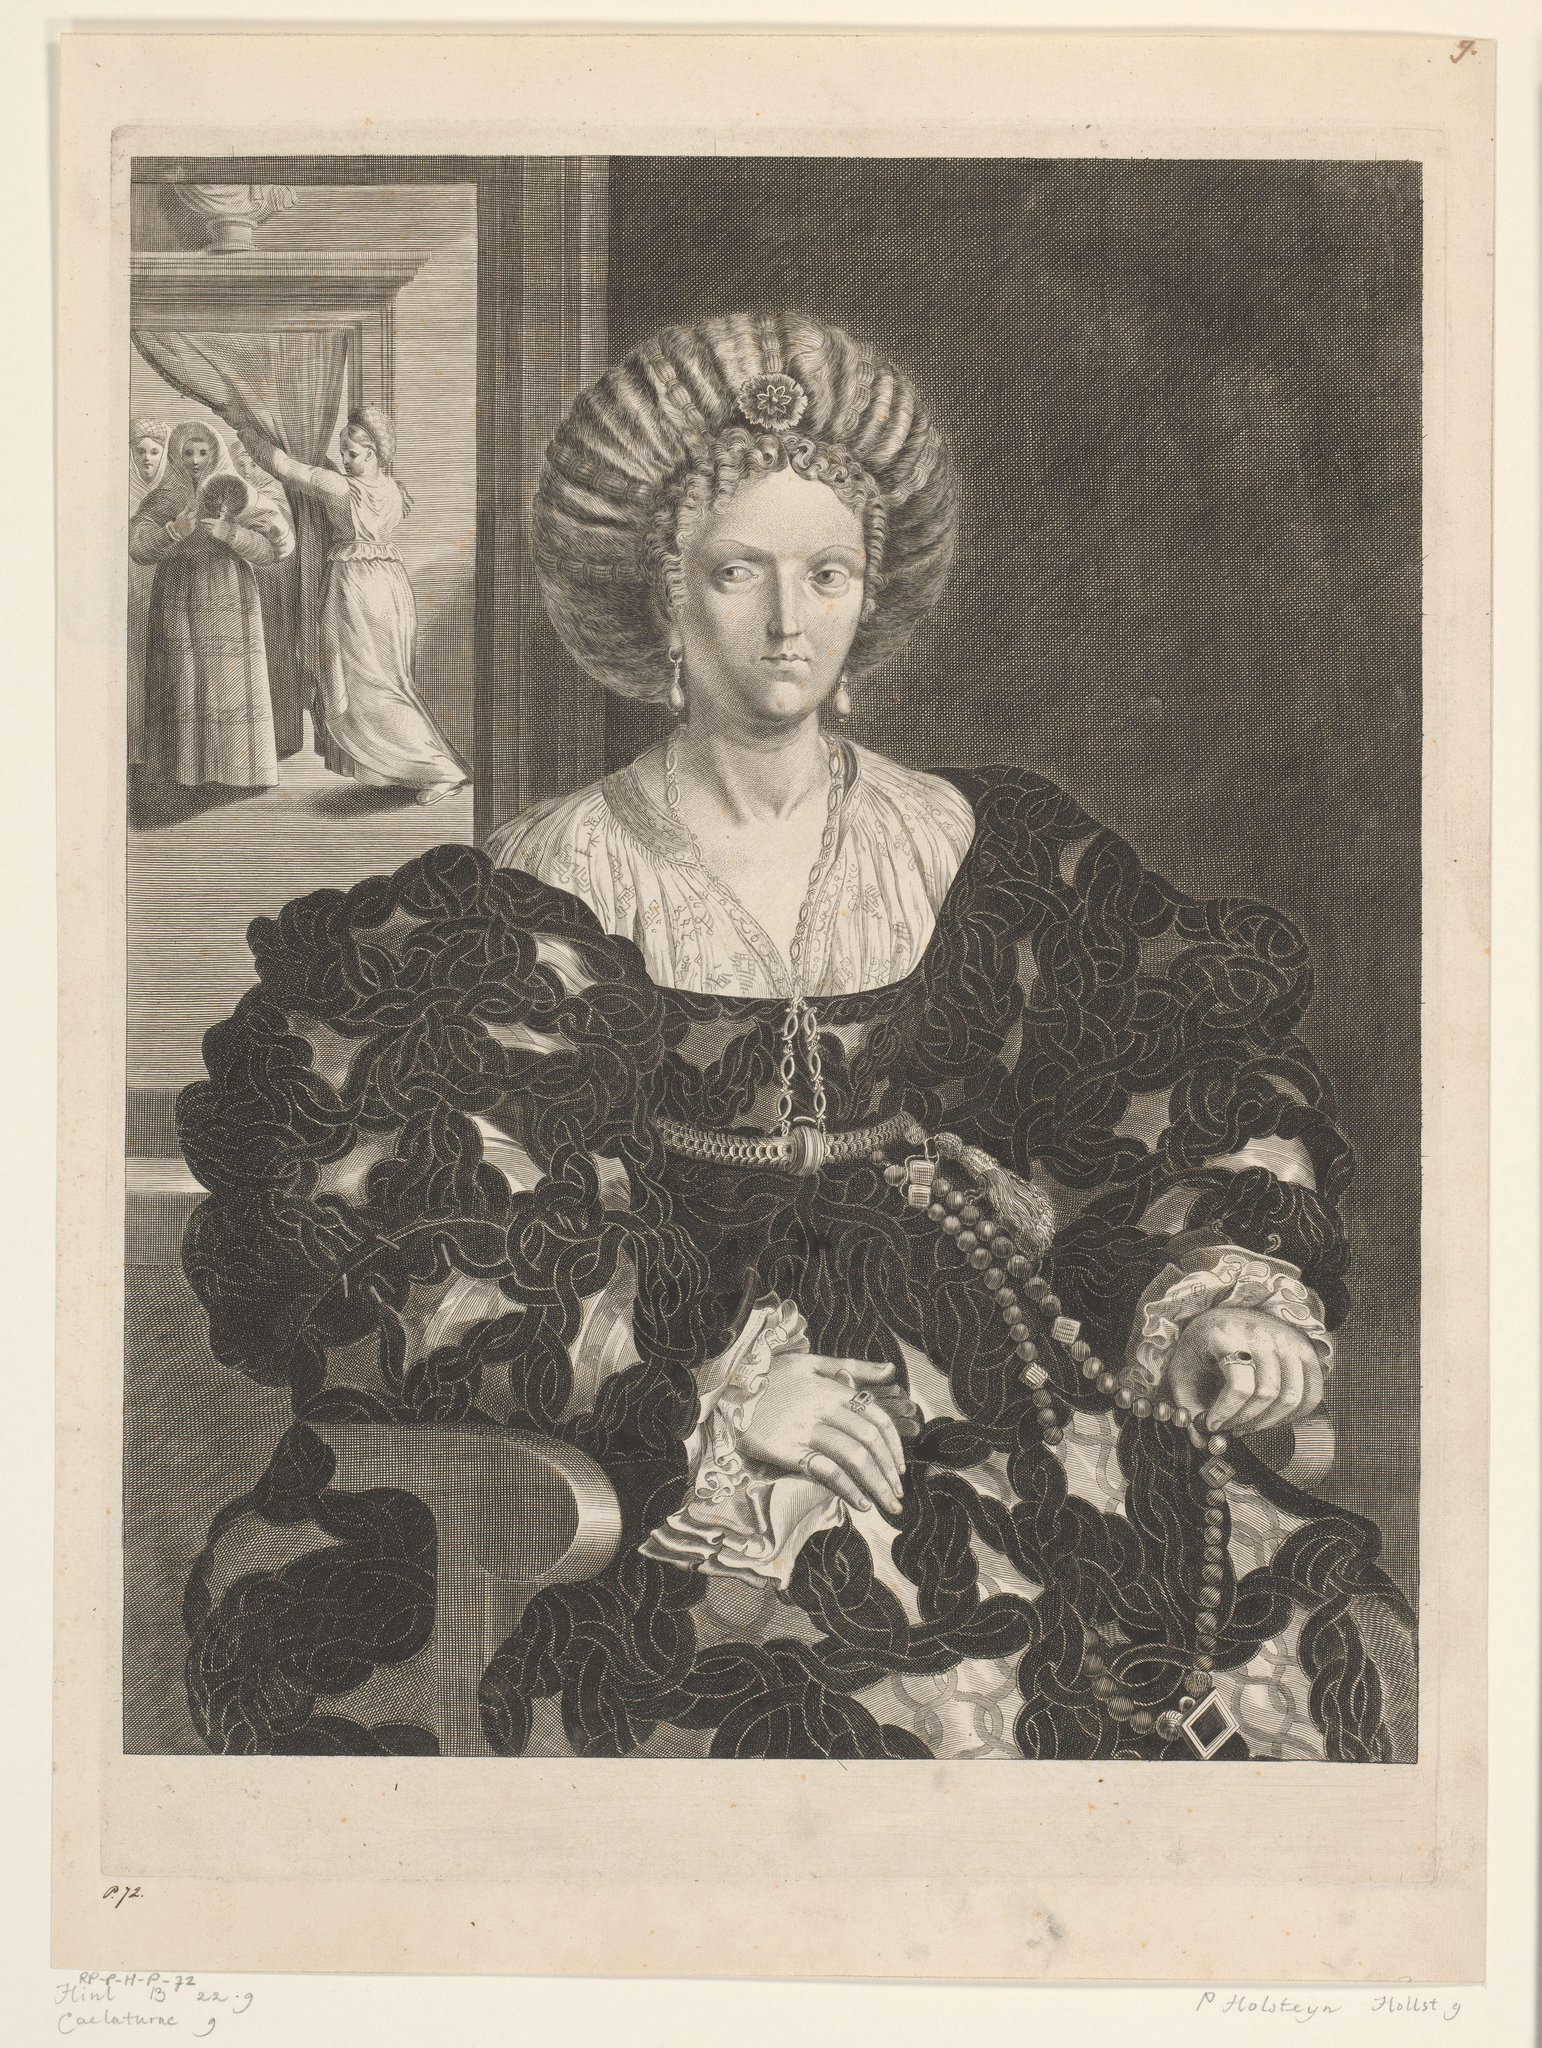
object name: print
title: Caelaturae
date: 1624-1673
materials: paper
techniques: engraving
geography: northern netherlands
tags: ferrara (stad), markiezin, isabella d' este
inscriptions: collector's mark: Lugt 11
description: Deze prent maakte ten minste tot 1979 deel uit van een prentalbum met de titel: 't Cabinet der Italiaense schilderije antique statue en borstbeelde van de heer Renst 145 stucks. Simon Schijnvoet heeft in 1709 aan dit album het Schijnvoet-nummer 22, liber nummer 20 toegekend. Prent uit serie Caelaturae met vierendertig reprodukties naar Italiaanse en Nederlandse schilders, vervaardigd door de allerbeste graveurs in opdracht van de verzamelaar Gerard Reynst.